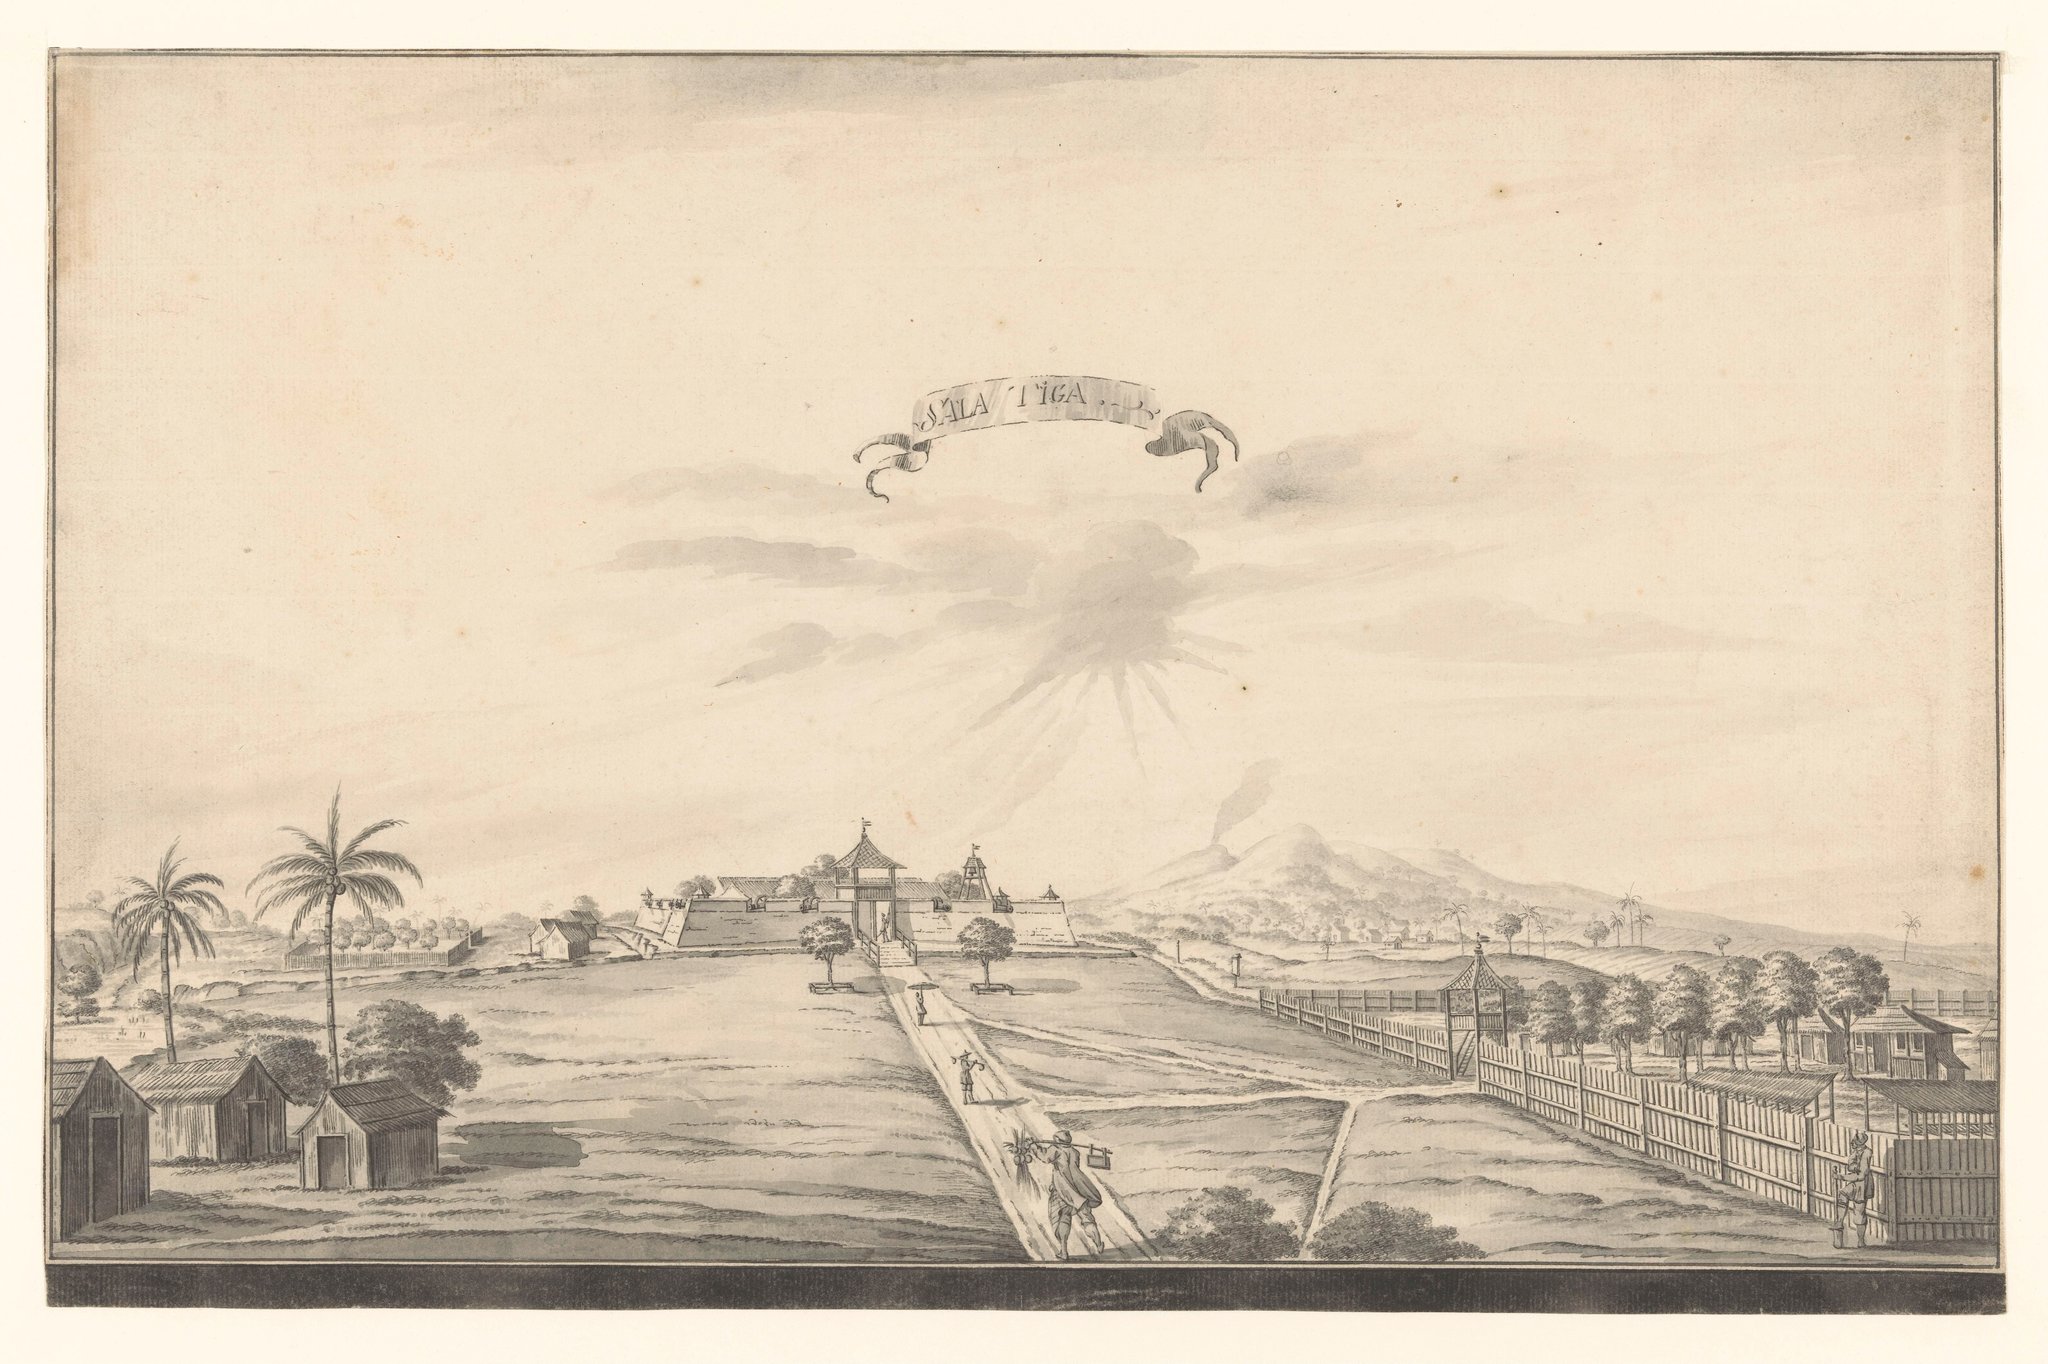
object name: drawing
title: Sala Tiga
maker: a. de nelly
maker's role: draughtsman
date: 1762-1783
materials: ink, paper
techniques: brush, pen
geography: salatiga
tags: fortress, java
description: Gezicht op het fort van de VOC te Salatiga. Weg naar de vesting in open land waarover drie figuren lopen. Links drie hutjes, rechts omheind terrein en boer leunend op schop. Heuvels op achtergrond.